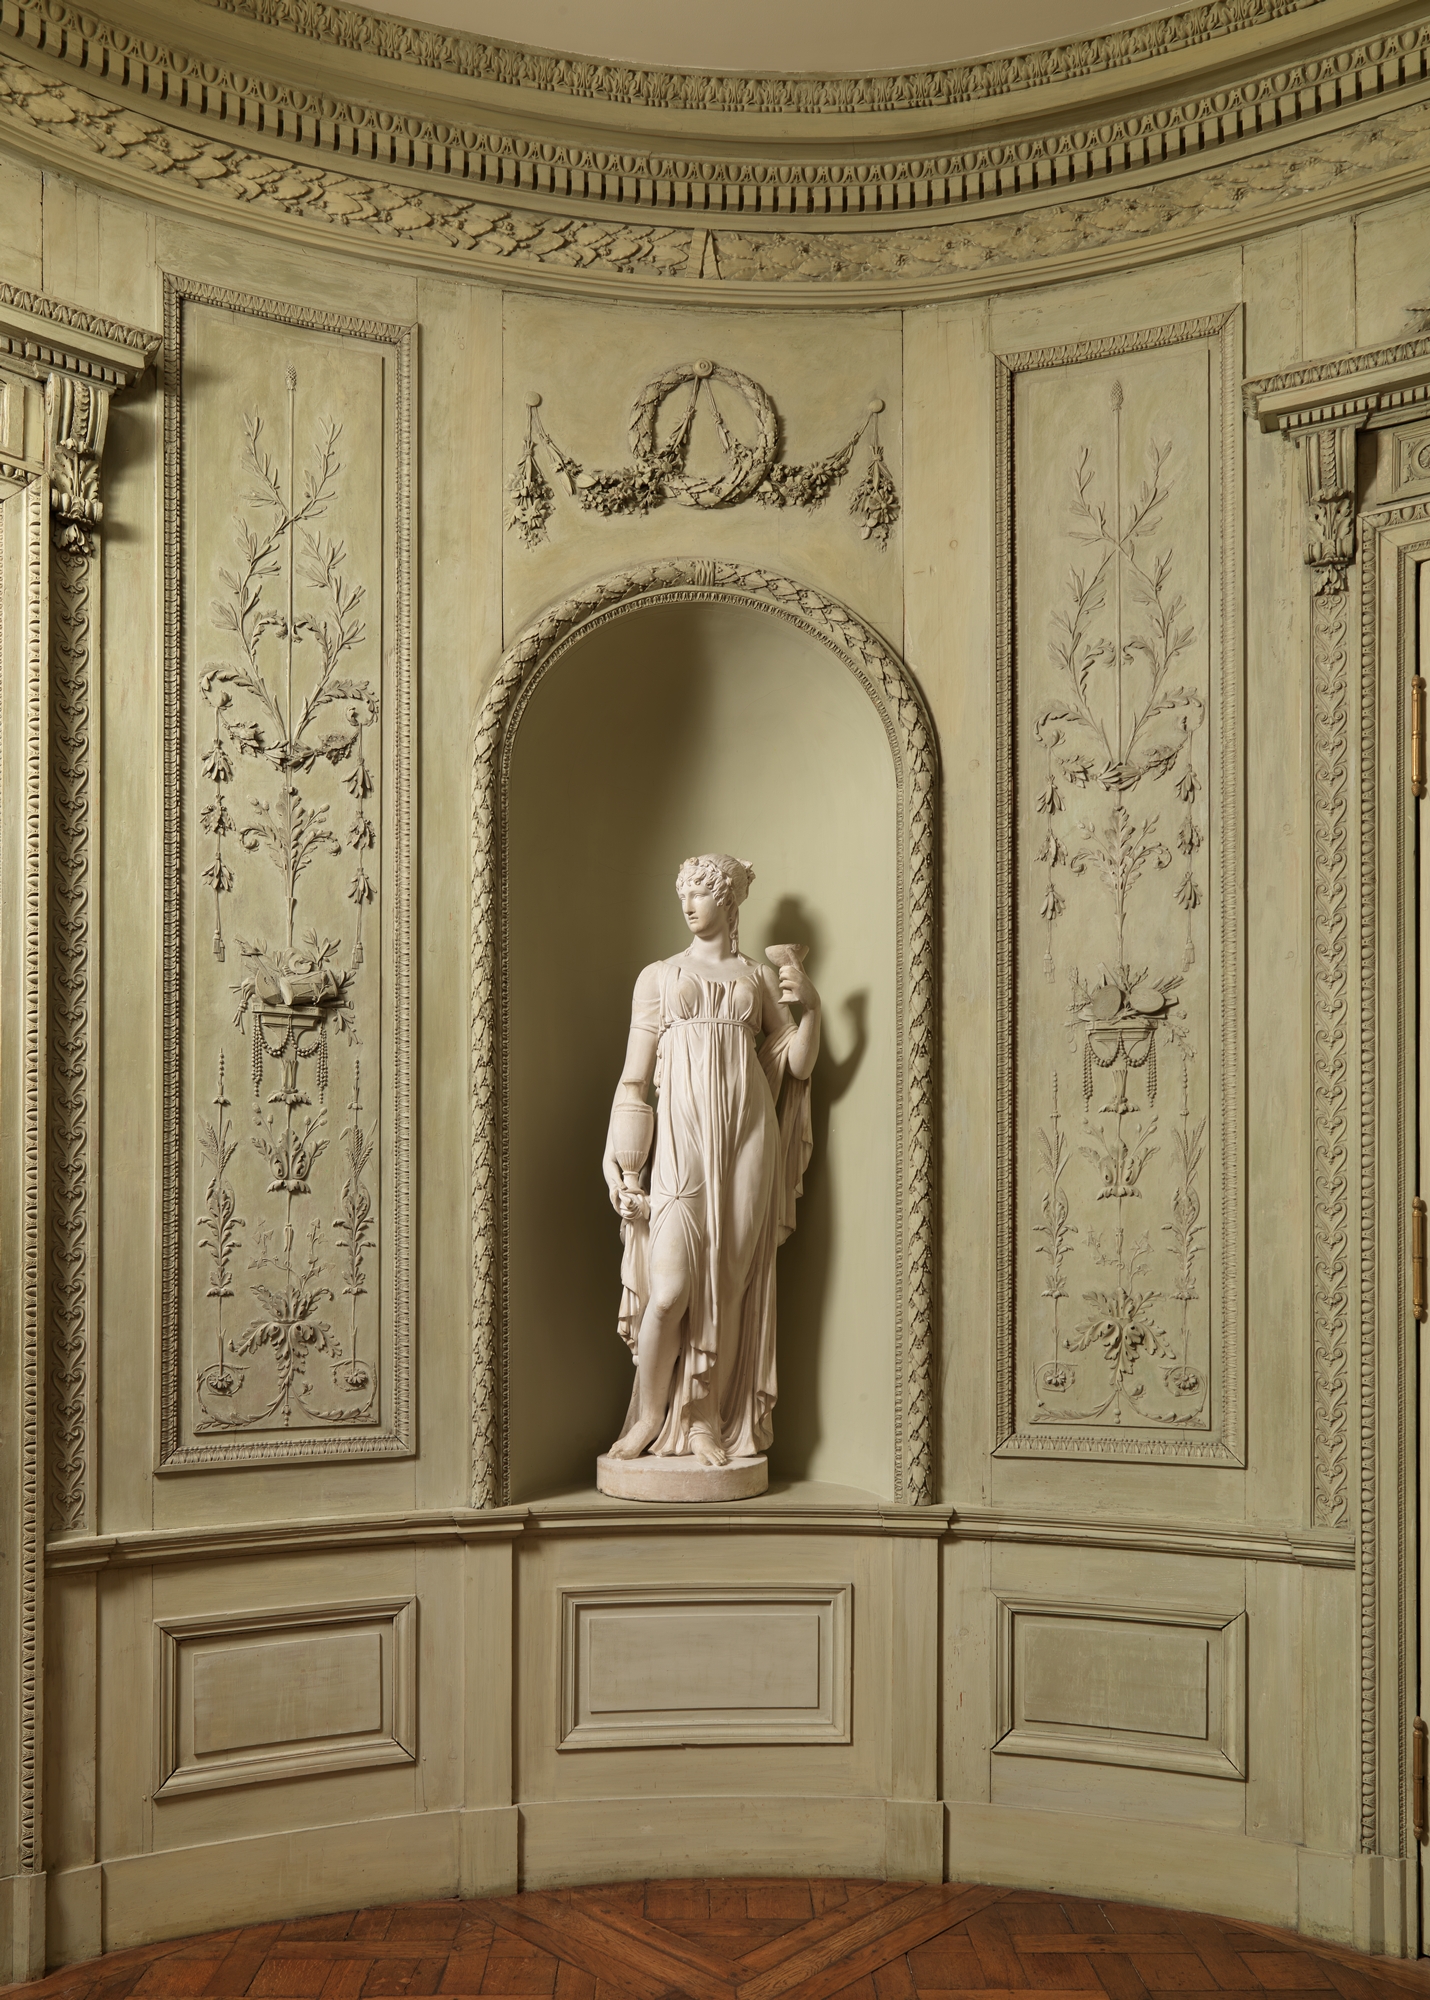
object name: statue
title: Nymph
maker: polly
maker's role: artist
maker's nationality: french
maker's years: 1795-1805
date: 1805-1810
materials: plaster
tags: nymphs